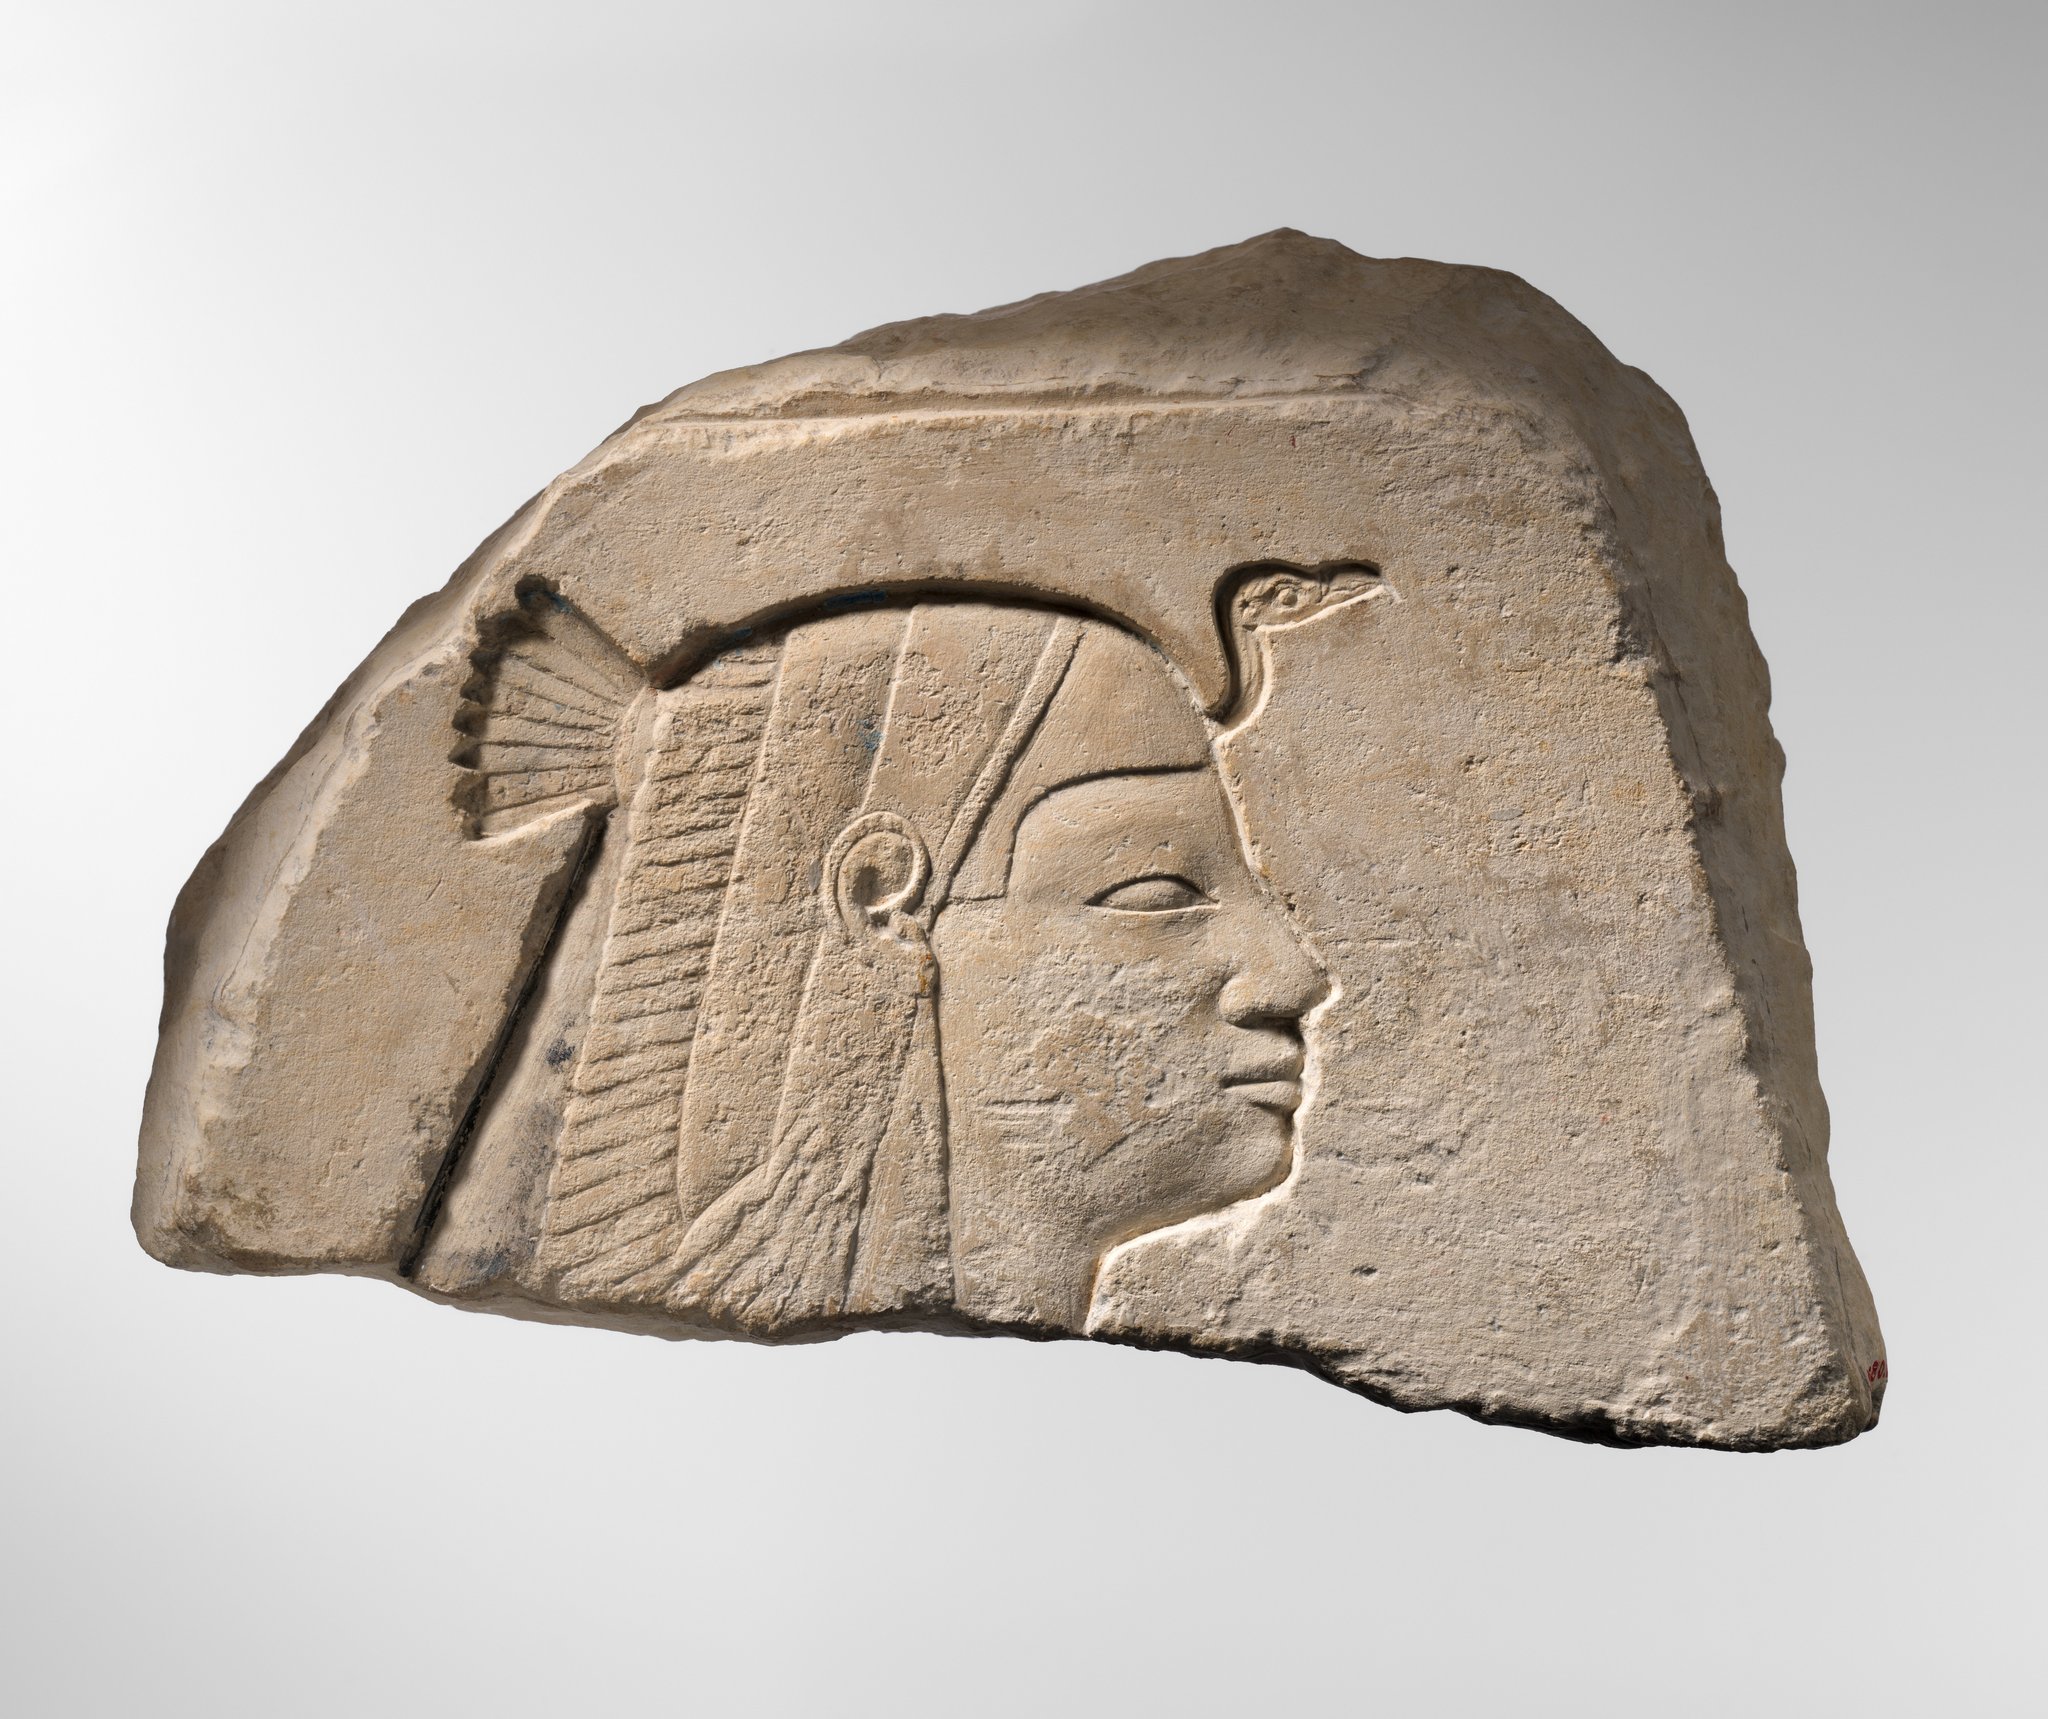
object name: relief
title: Head of a Queen or Goddess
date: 1961-1917 BCE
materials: limestone, paint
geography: egypt